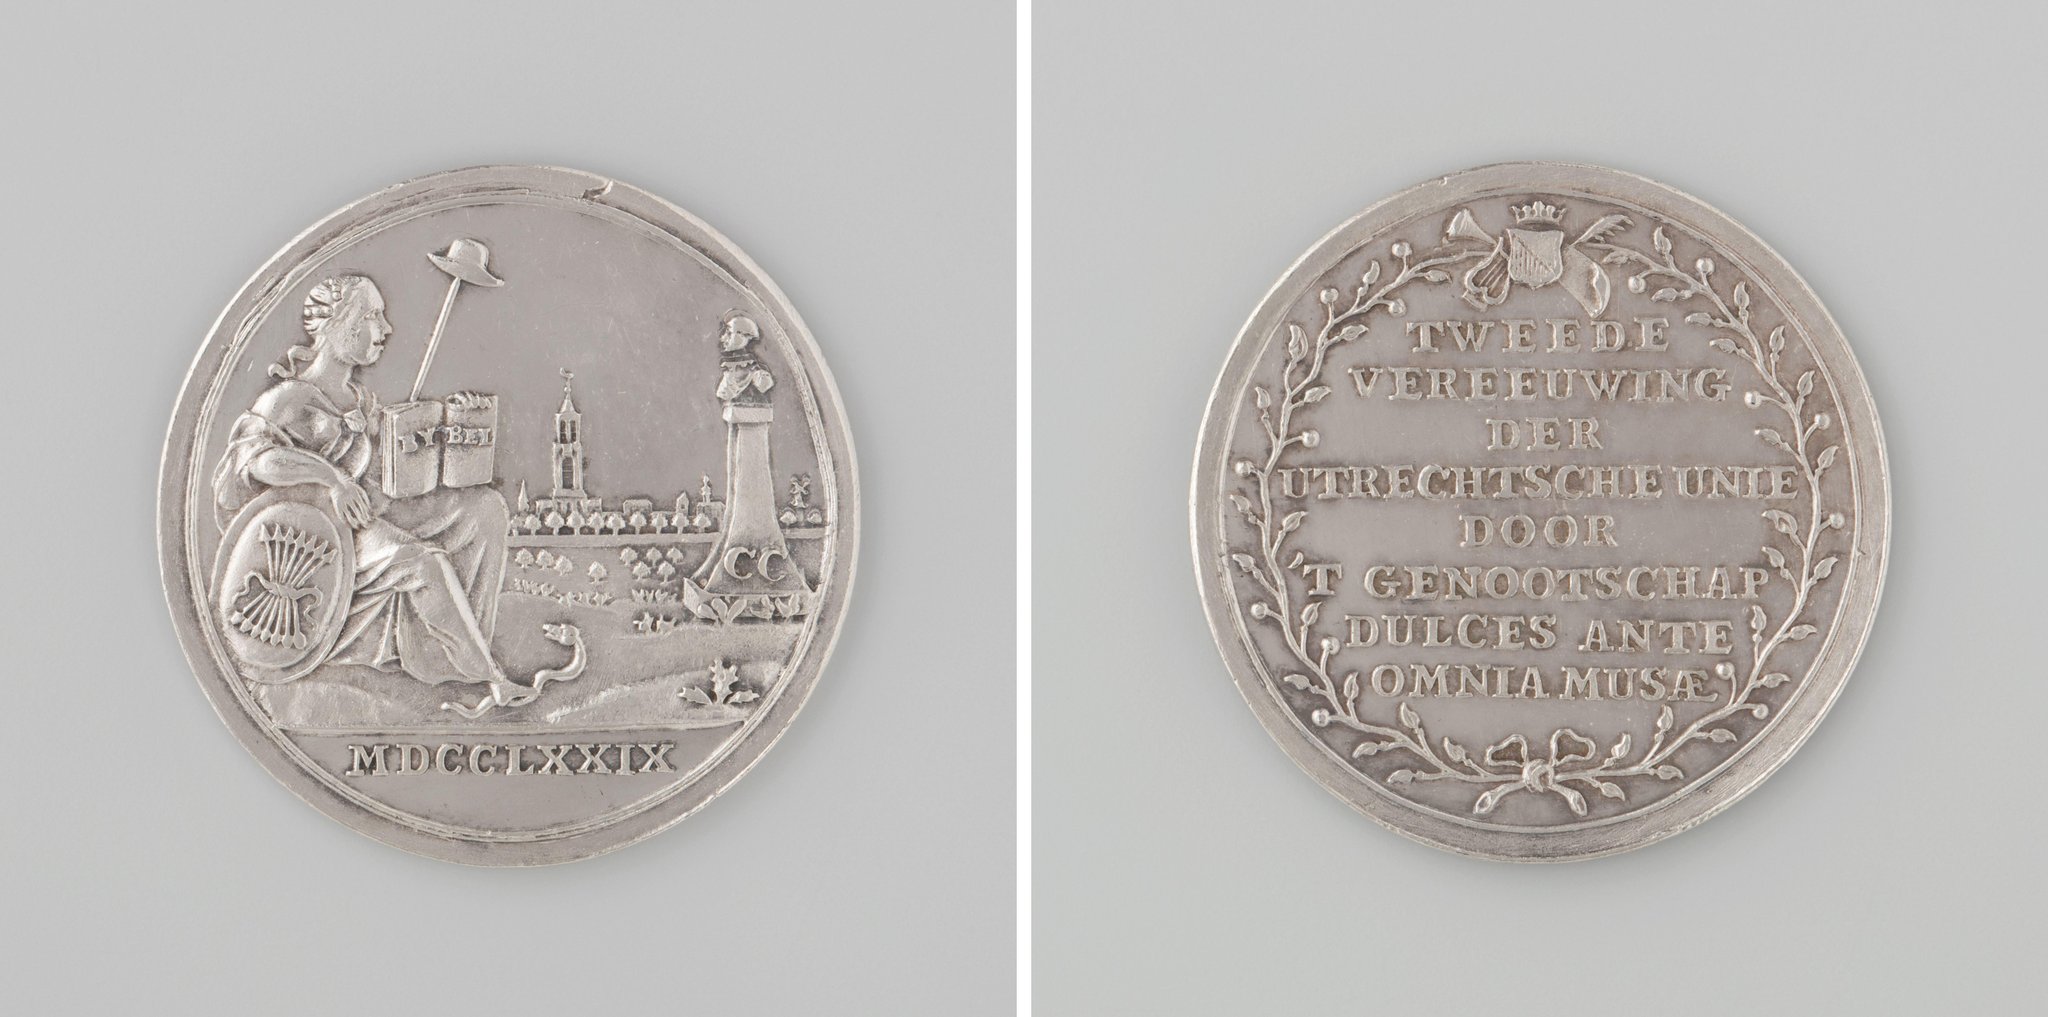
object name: history medal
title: Tweehonderdste verjaardag van de Unie van Utrecht, penning door het genootschap "Dulces ante omnia musae" geslagen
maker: Anonymous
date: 1779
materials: silver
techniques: striking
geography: netherlands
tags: delft, william i (prince of orange), utrecht, union of utrecht